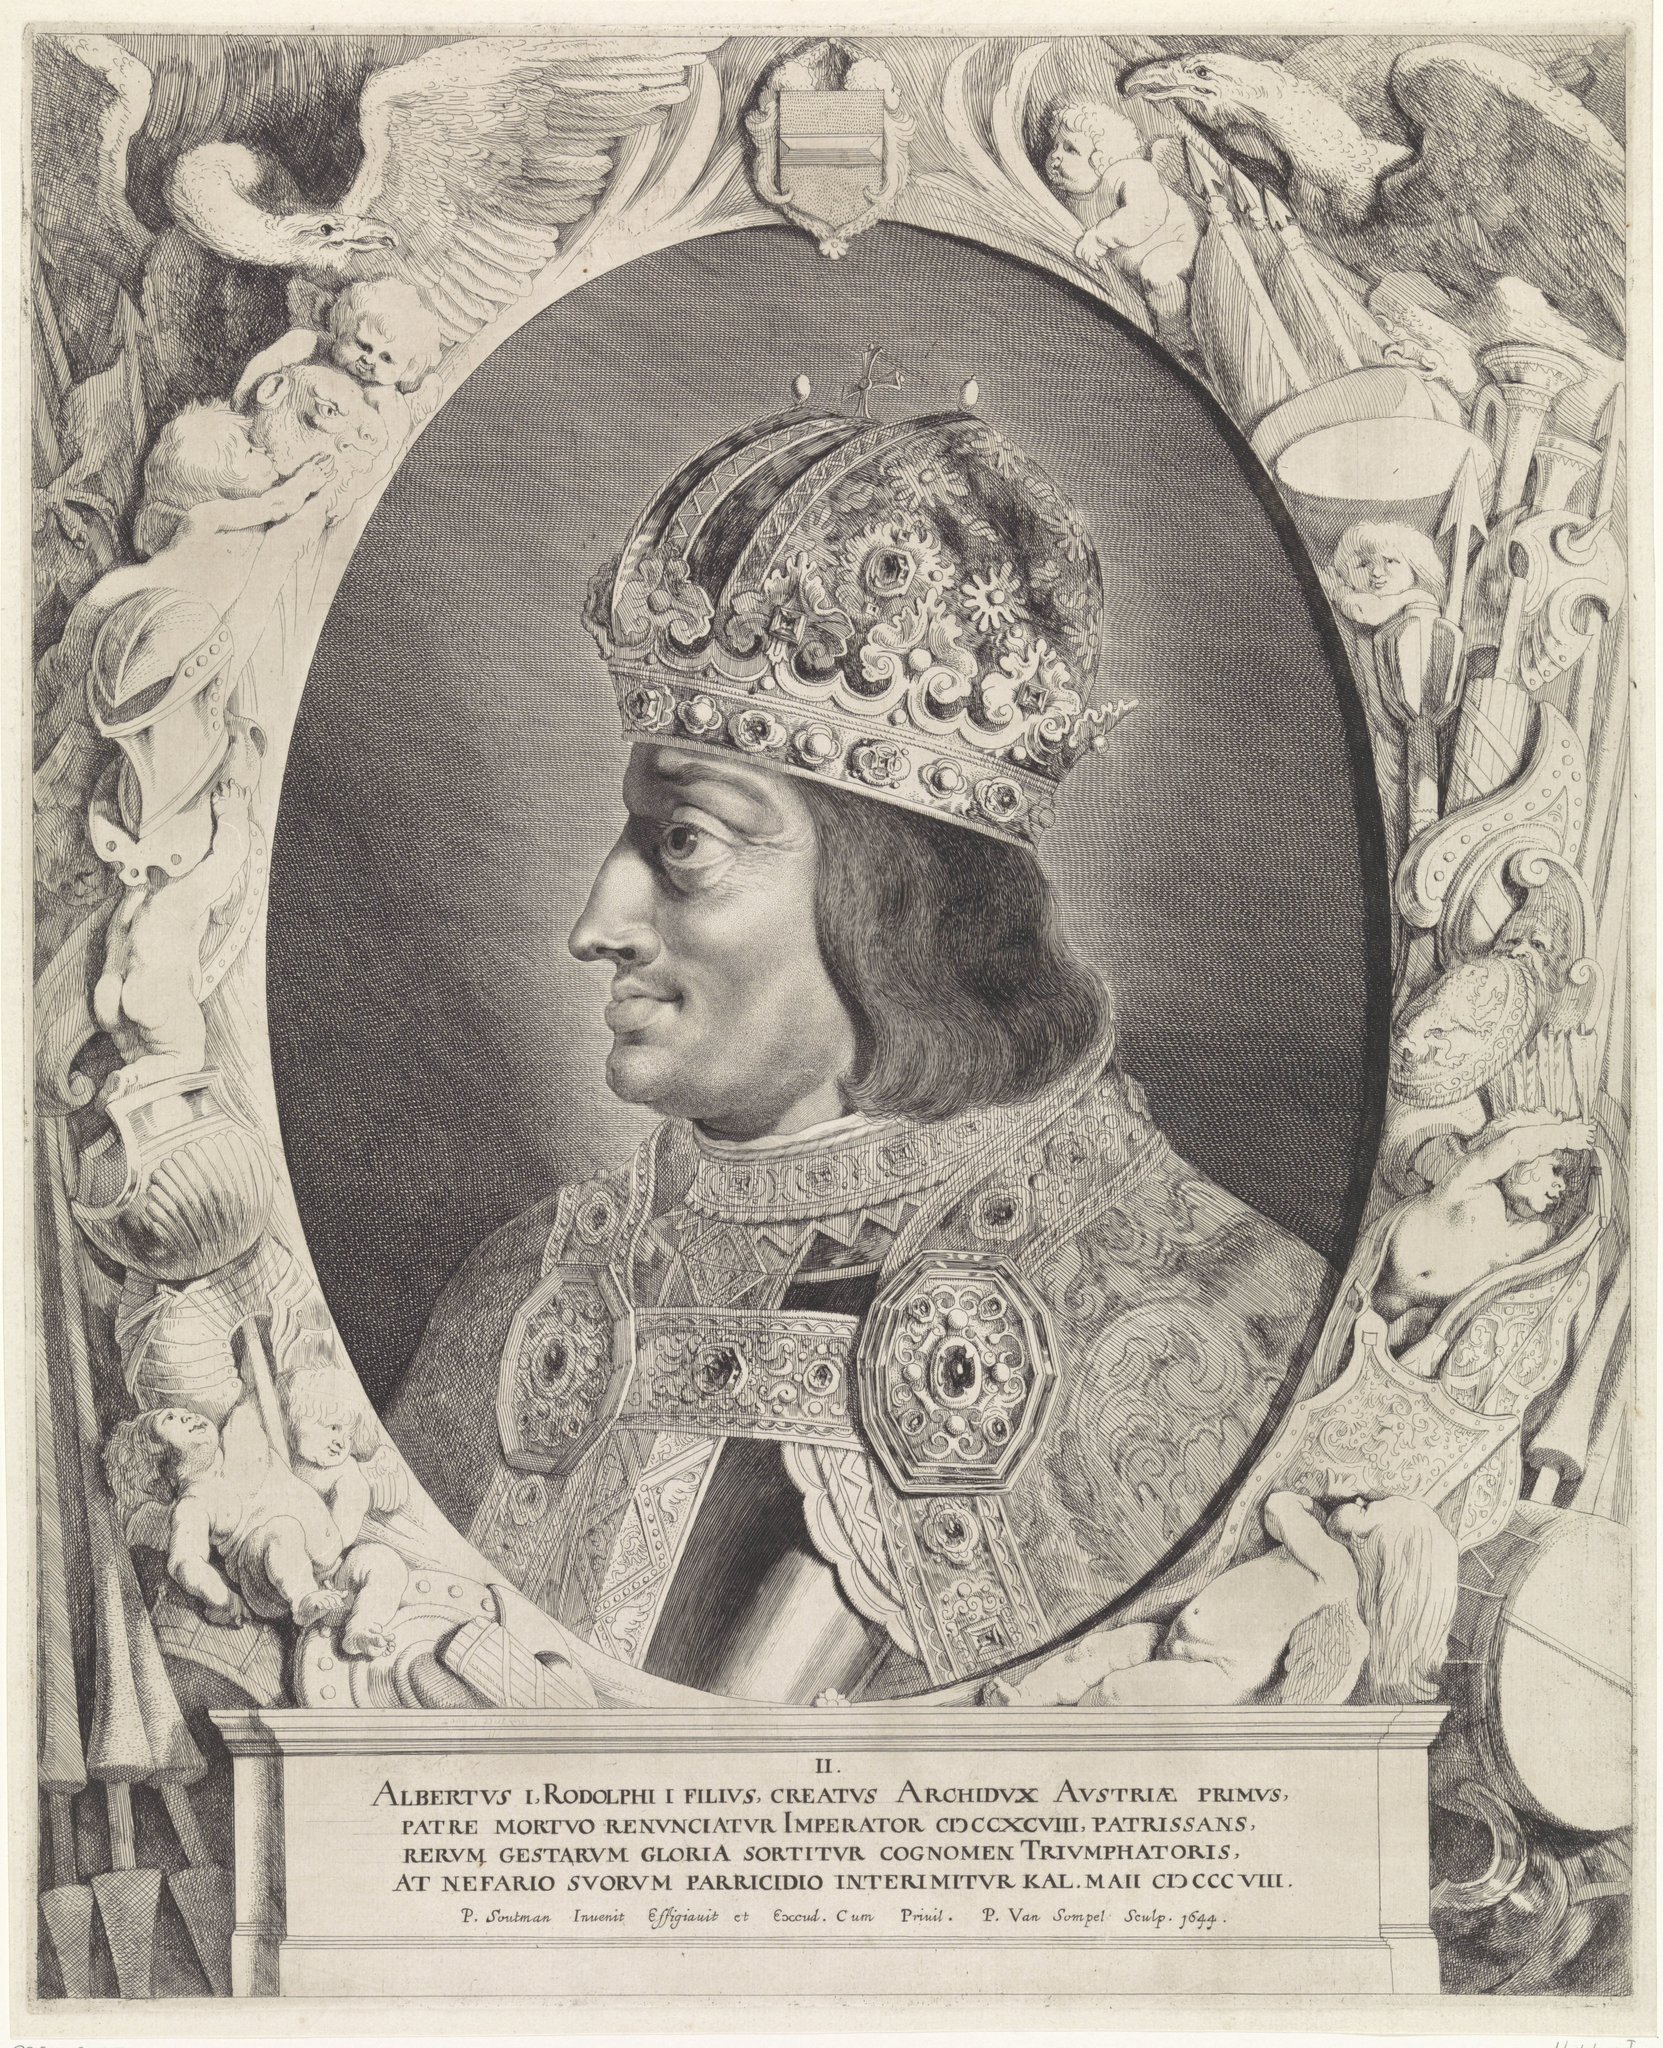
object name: print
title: Effigies Imperatorum domus Austriacae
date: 1644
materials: paper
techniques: engraving, etching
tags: koning, albrecht i van habsburg (rooms-duits koning)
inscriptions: collector's mark: Lugt 2228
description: Portret van Albrecht I van Habsburg (Rooms-Duits koning). Het portret wordt omlijst door een randversiering met putti, fasces en wapenuitrusting. In de beide bovenhoeken een adelaar, in het midden zijn wapenschild. Onder het portret een cartouche met in het Latijn zijn naam, titels en een korte levensbeschrijving. Genummerd "II".